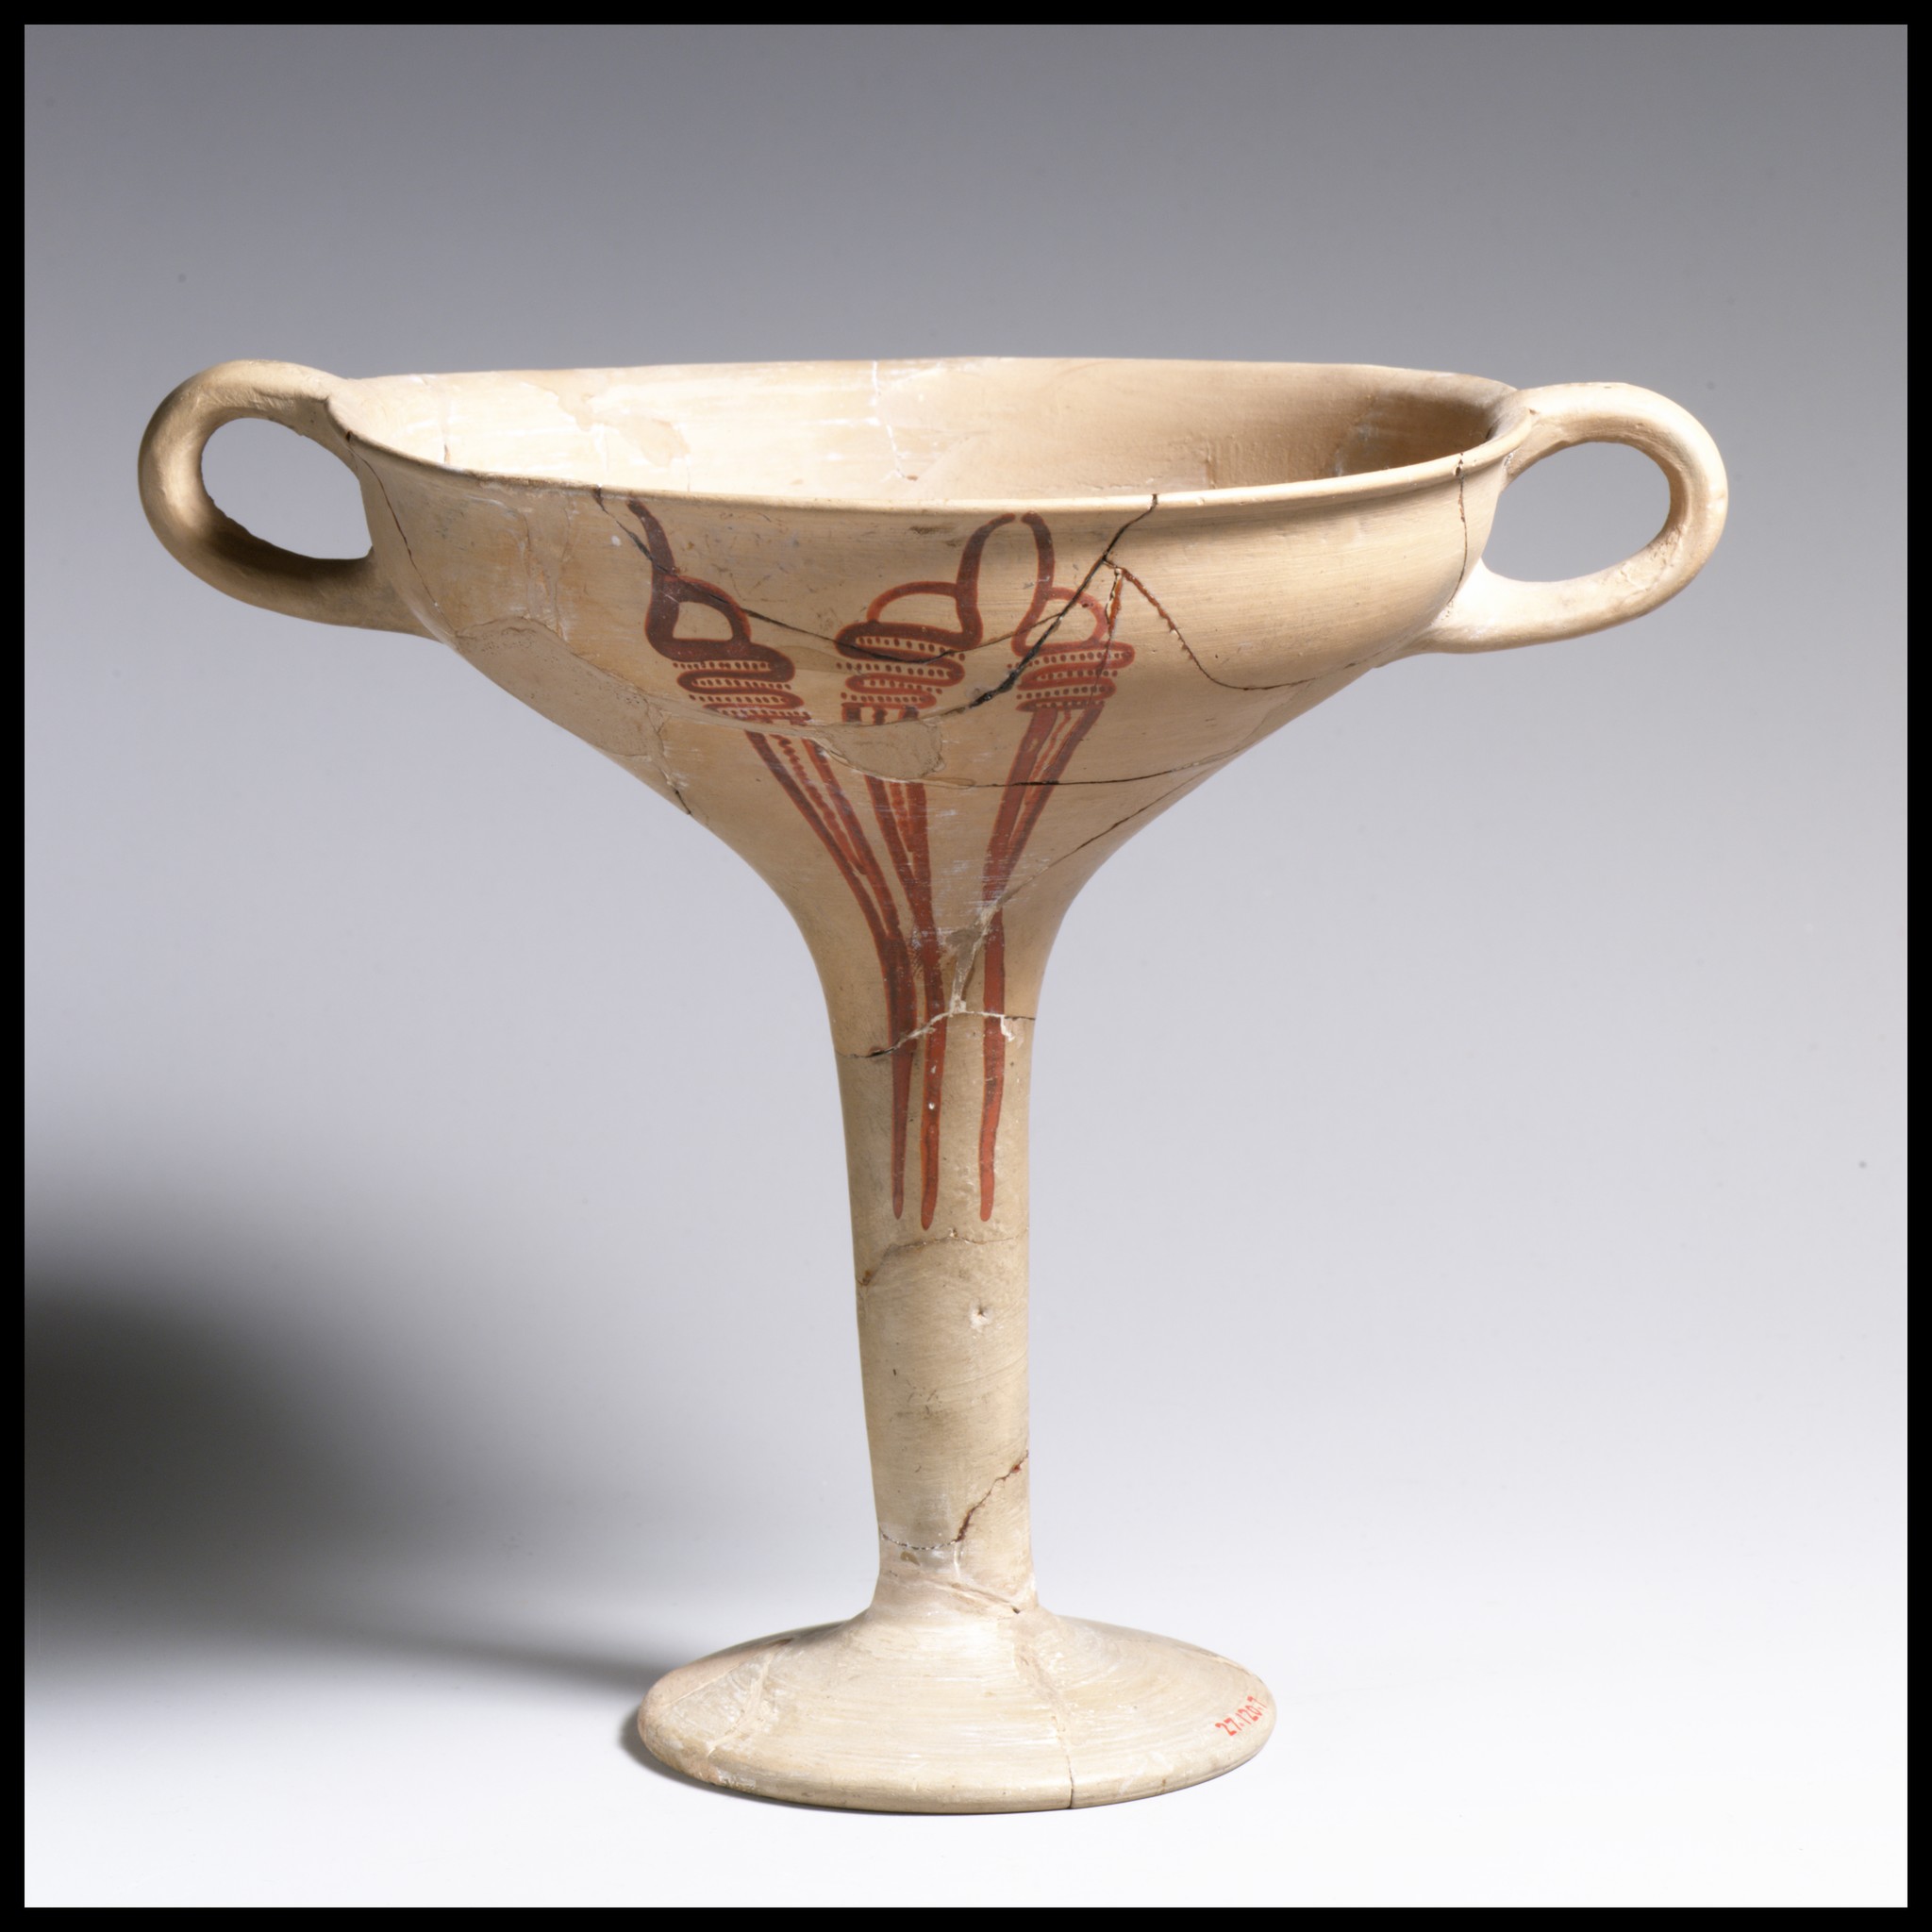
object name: kylix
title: Terracotta kylix (drinking cup) with whorl shells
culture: mycenaean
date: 1300-1190 BCE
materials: terracotta